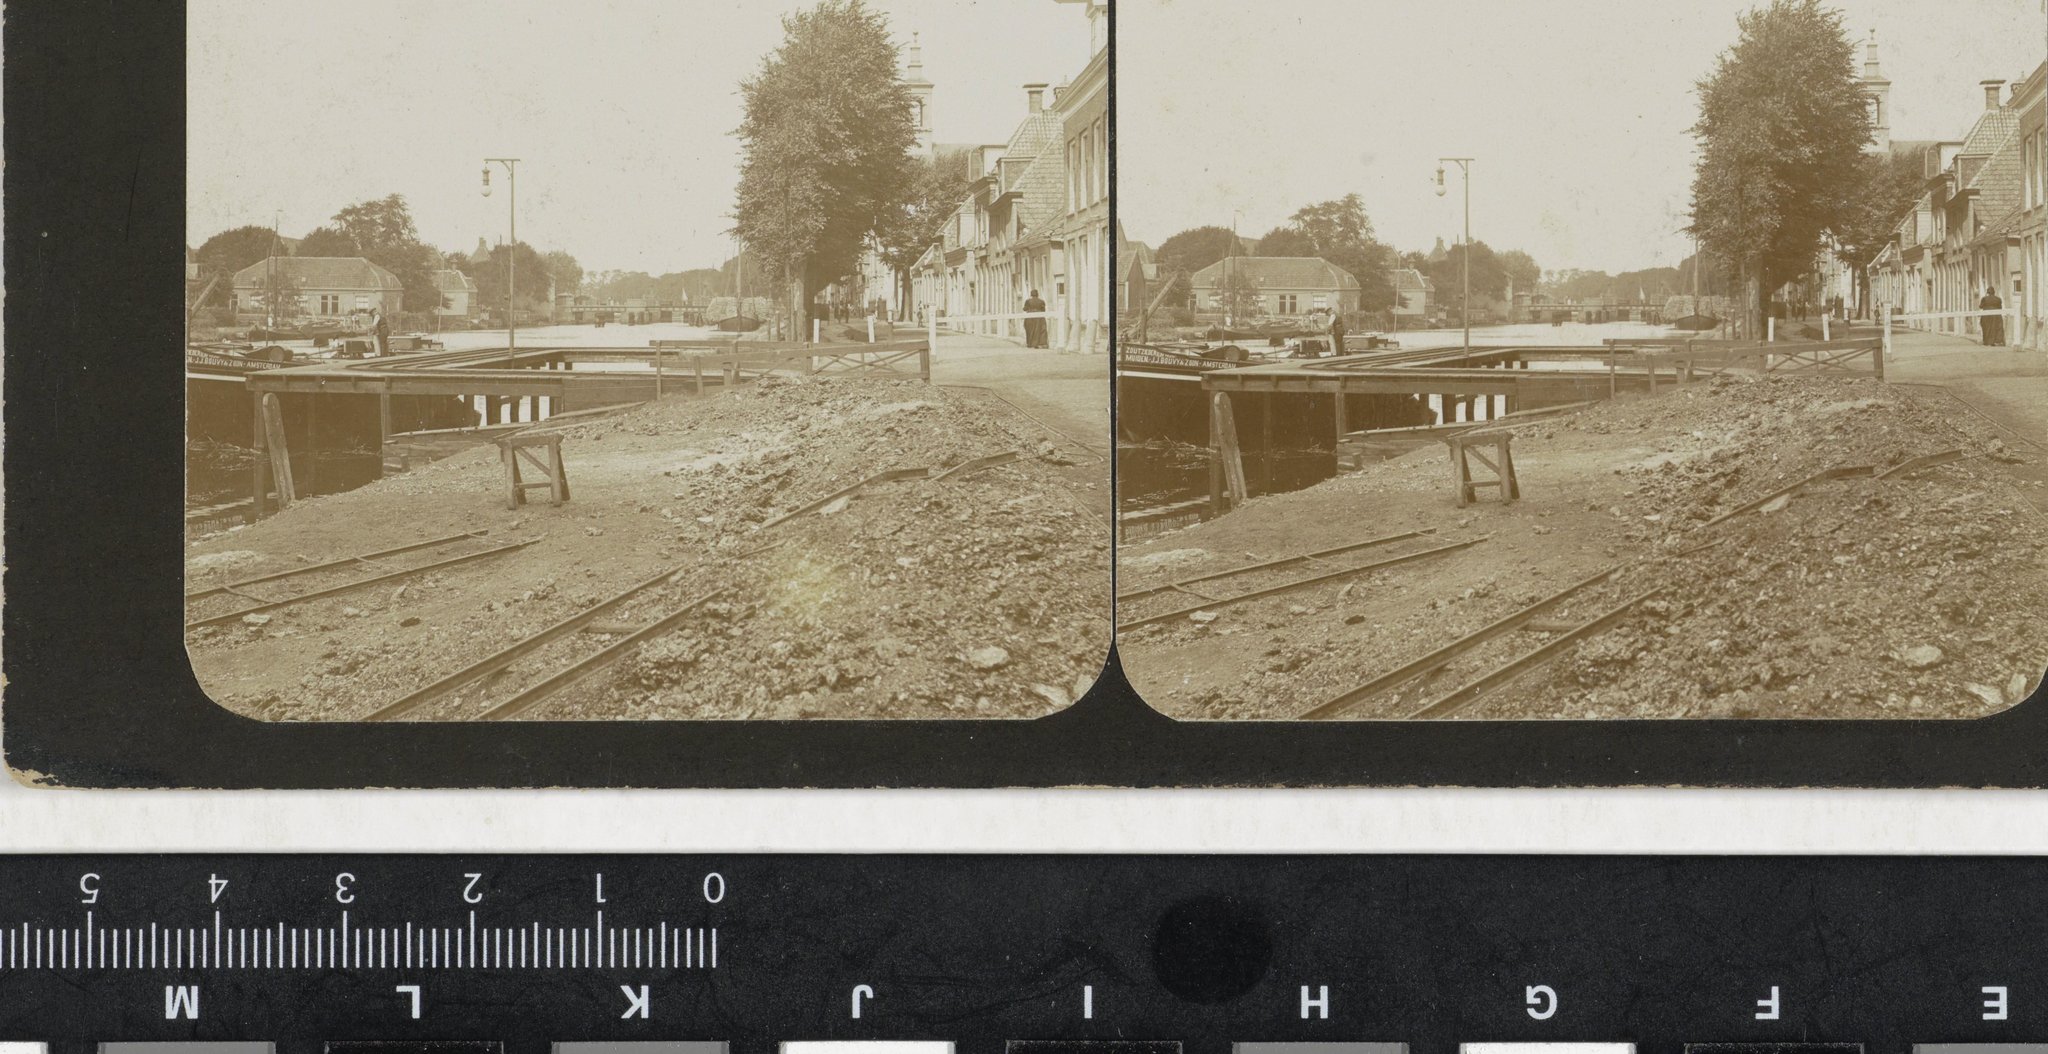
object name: stereograph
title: Muiden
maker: Anonymous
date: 1880-1920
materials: cardboard, photographic support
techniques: collodion silver print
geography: muiden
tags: harbour, pier, quay, wharf, civic architecture; edifices; dwellings